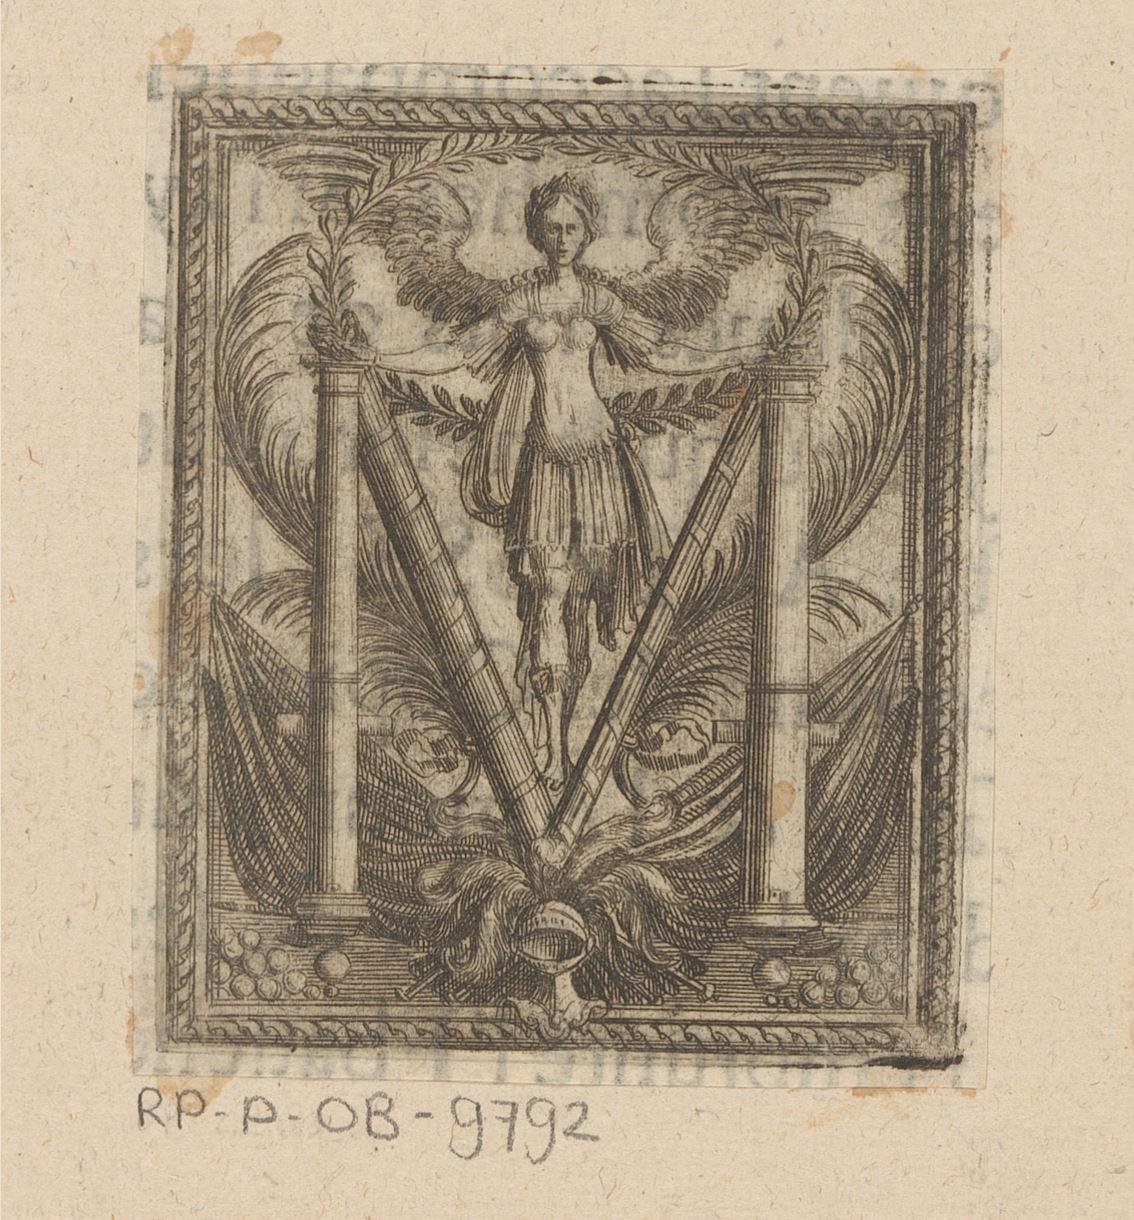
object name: ornament print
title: Vignet met engel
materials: paper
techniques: etching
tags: ornaments ~ art, vignette, angels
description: Prent uit: Bardin, Philippe. Le Triomphe De Son Altesse Charles IIII (...). Nancy: Poirel, Dominique, Charlot Anthoine en Charlot Claude, 1664.